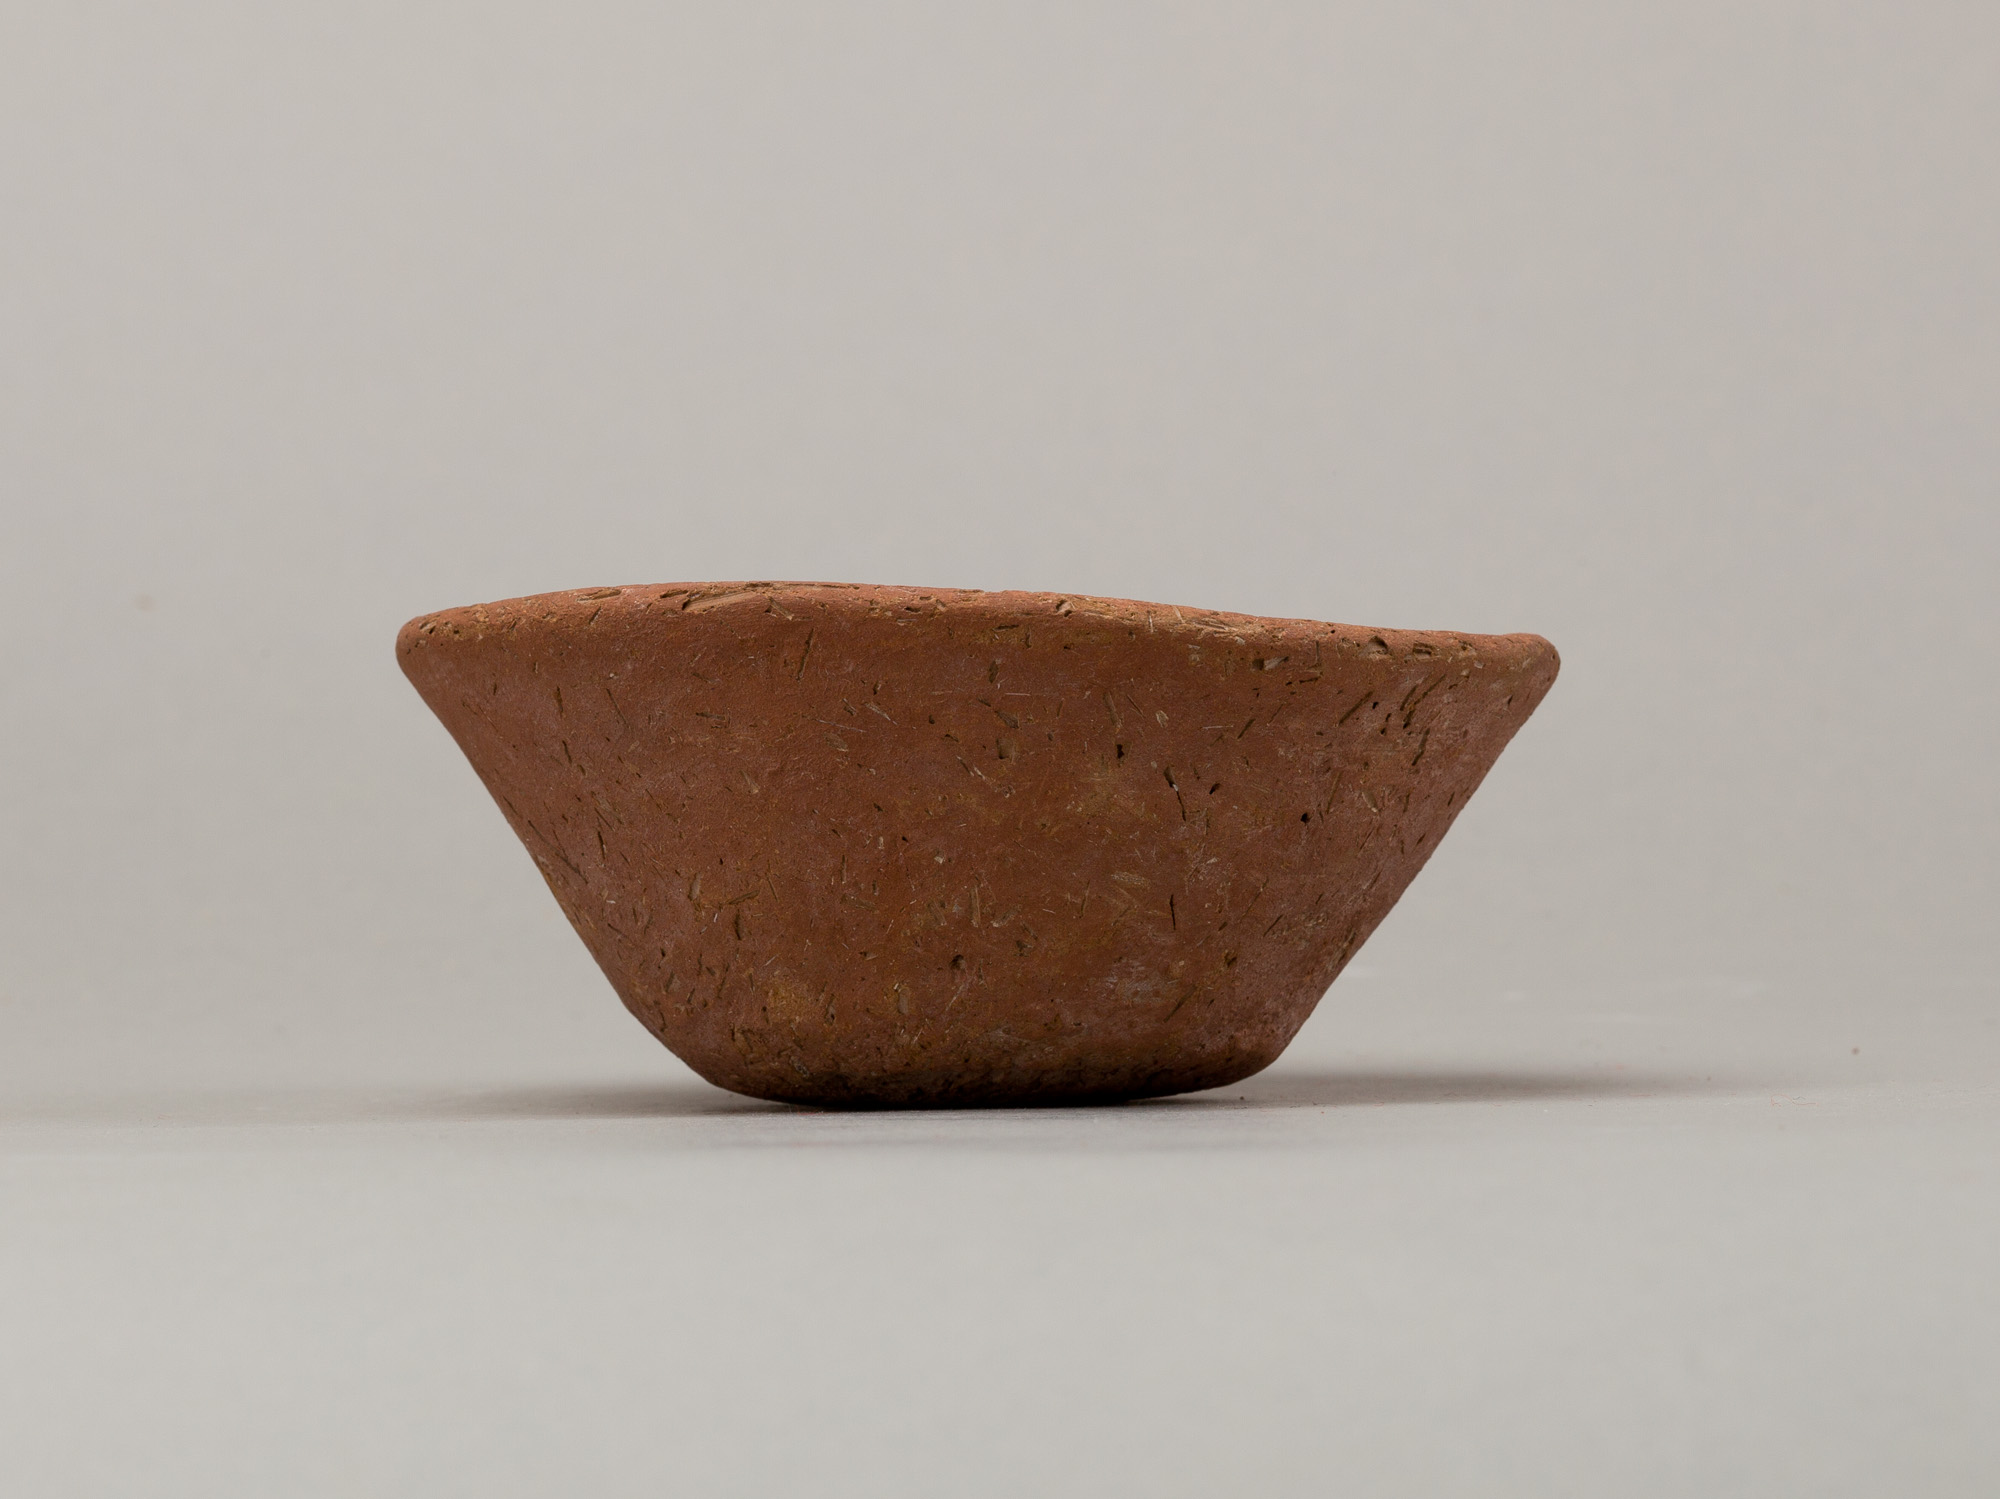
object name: bowl, rough ware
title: Rough ware bowl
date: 3850-2960 BCE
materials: pottery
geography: egypt